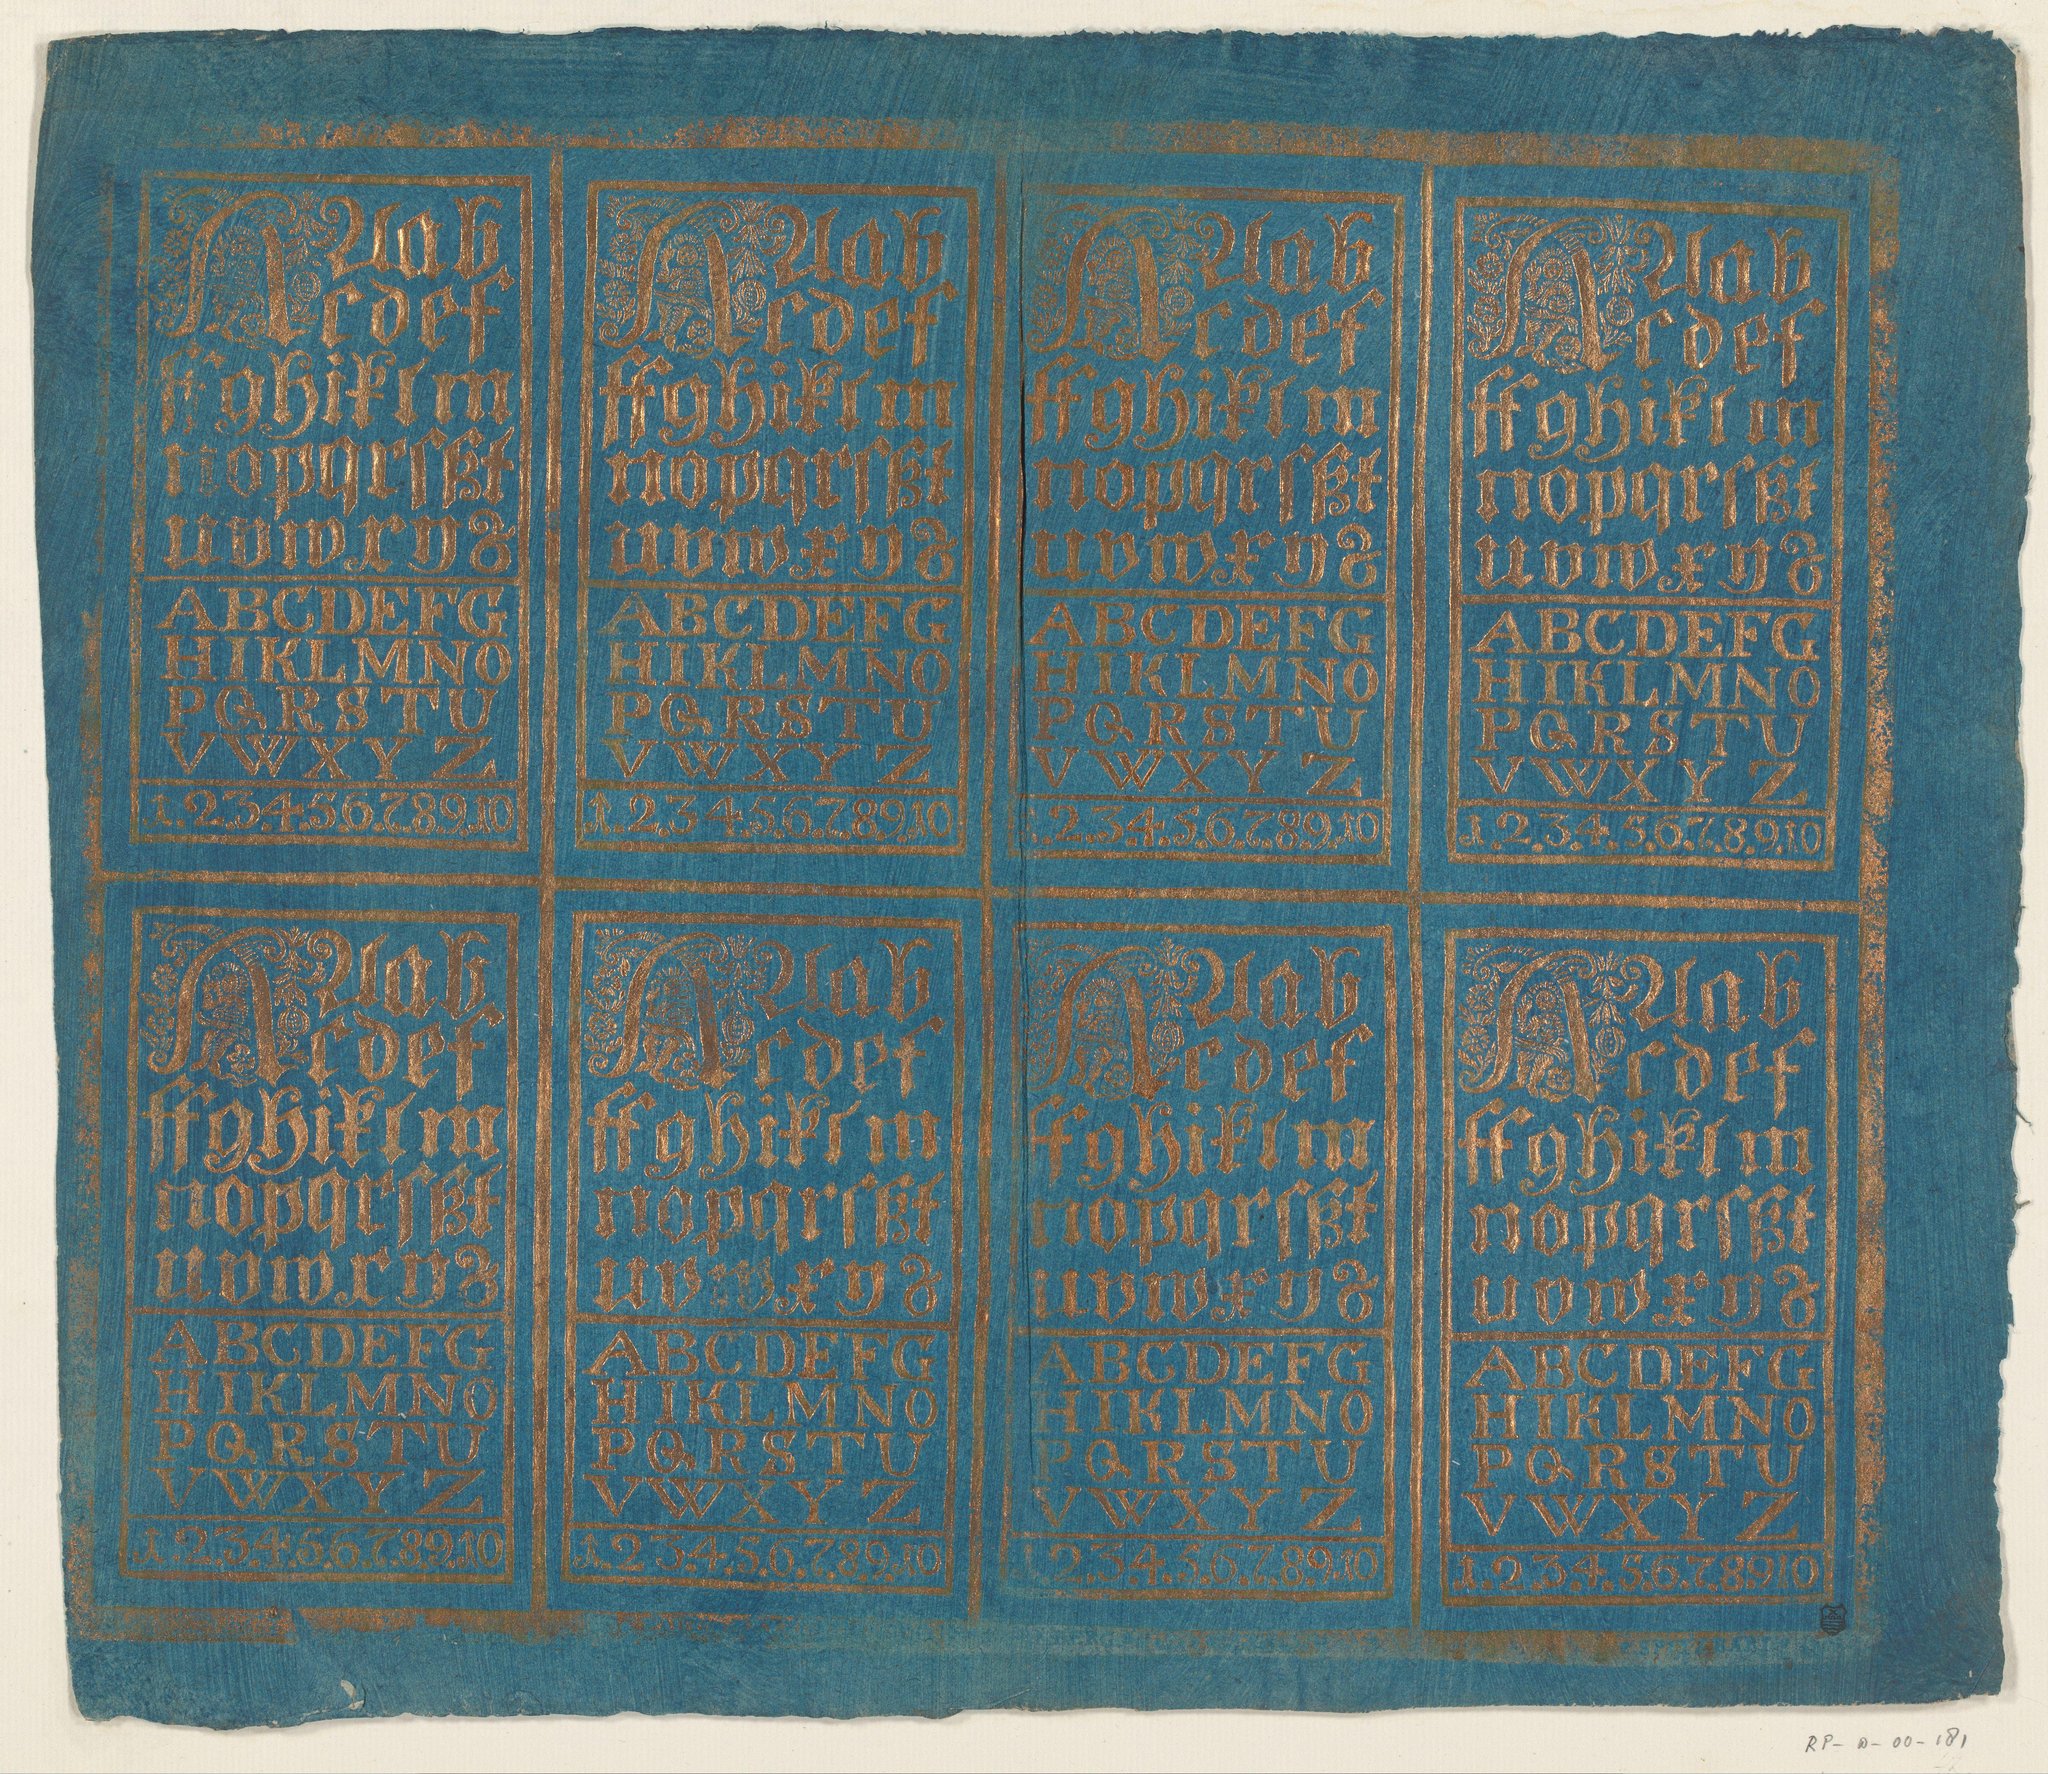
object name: brocade paper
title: Blad met in twee rijen van vier tafel met alfabet en cijfers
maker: paul reimund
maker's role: sierpapiermaker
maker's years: 1764-1815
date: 1773-1815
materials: gold leaf, paint, paper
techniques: relief print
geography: nuremberg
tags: letters, alphabet, script, historiated initial, numerals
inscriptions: collector's mark: Lugt 2760, collector's mark: Lugt 2228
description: Blad met acht tafels, elk met twee alfabetten en een cijfersreeks ,in de eerste letter A het kindeke Jezus. Rechtsonder genummerd: 60.